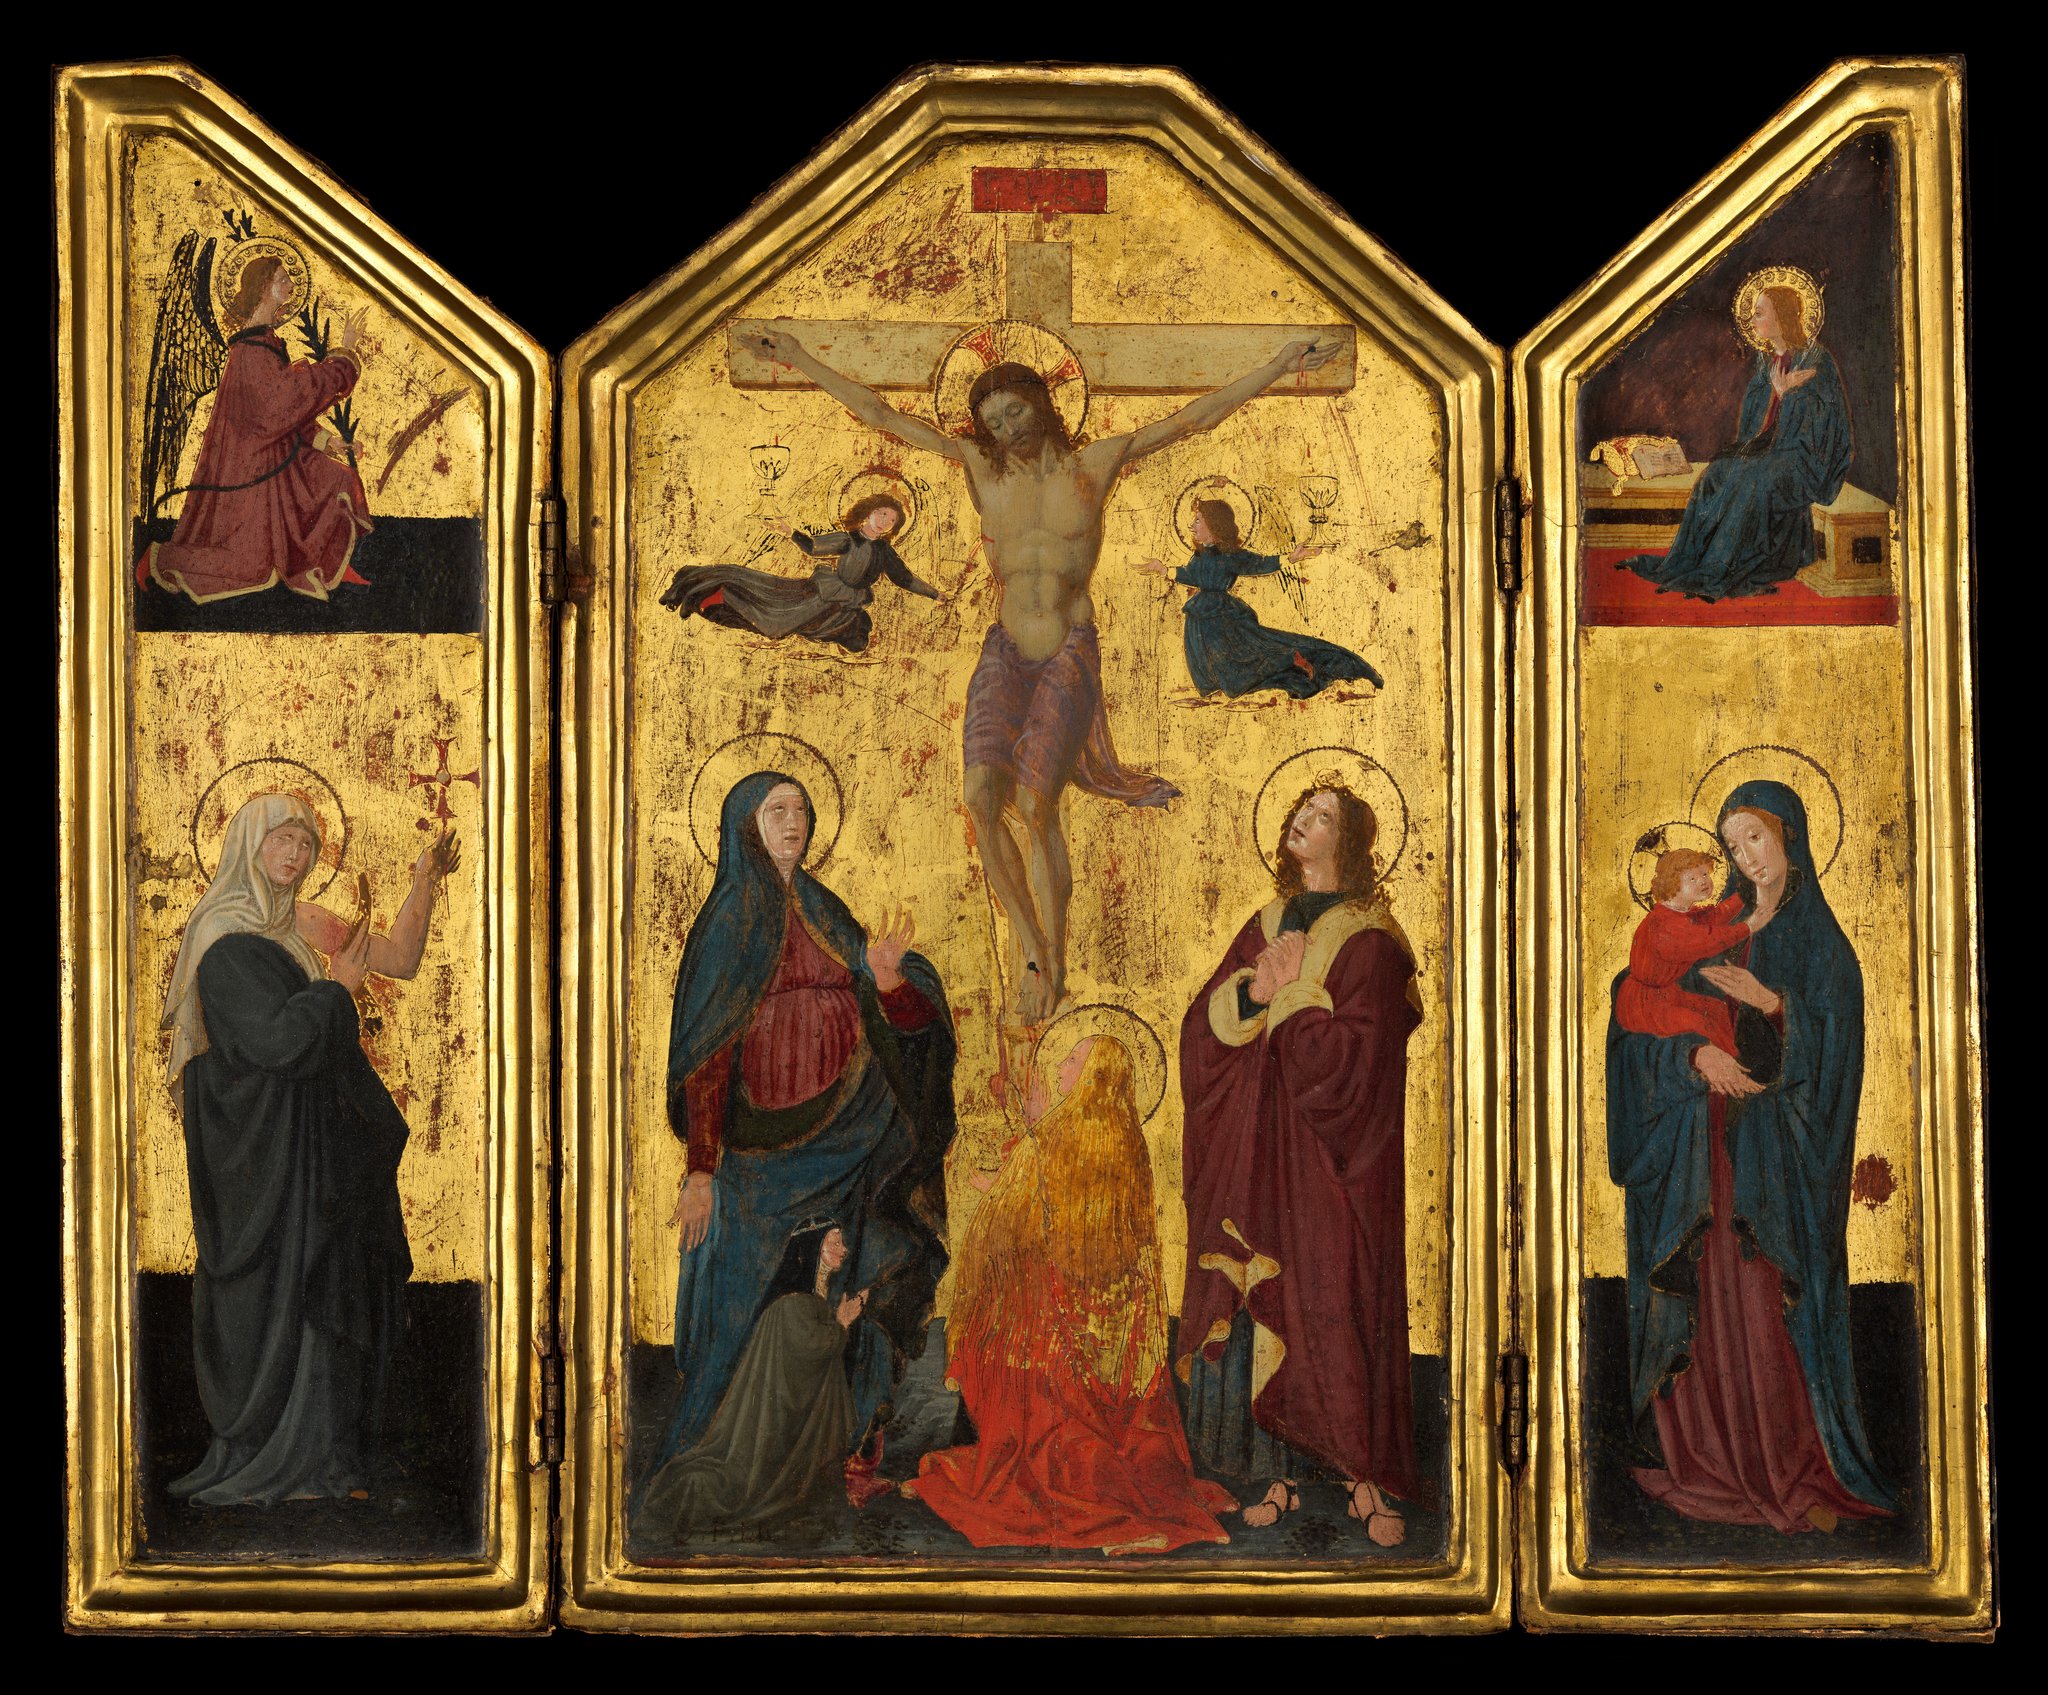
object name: painting, triptych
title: The Crucifixion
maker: paolo uccello (paolo di dono)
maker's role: artist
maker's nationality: italian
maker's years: 1397-1475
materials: gold leaf, paint, wood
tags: women,angels,christ,madonna and child,mary magdalene,saint john the evangelist,crucifixion,nuns